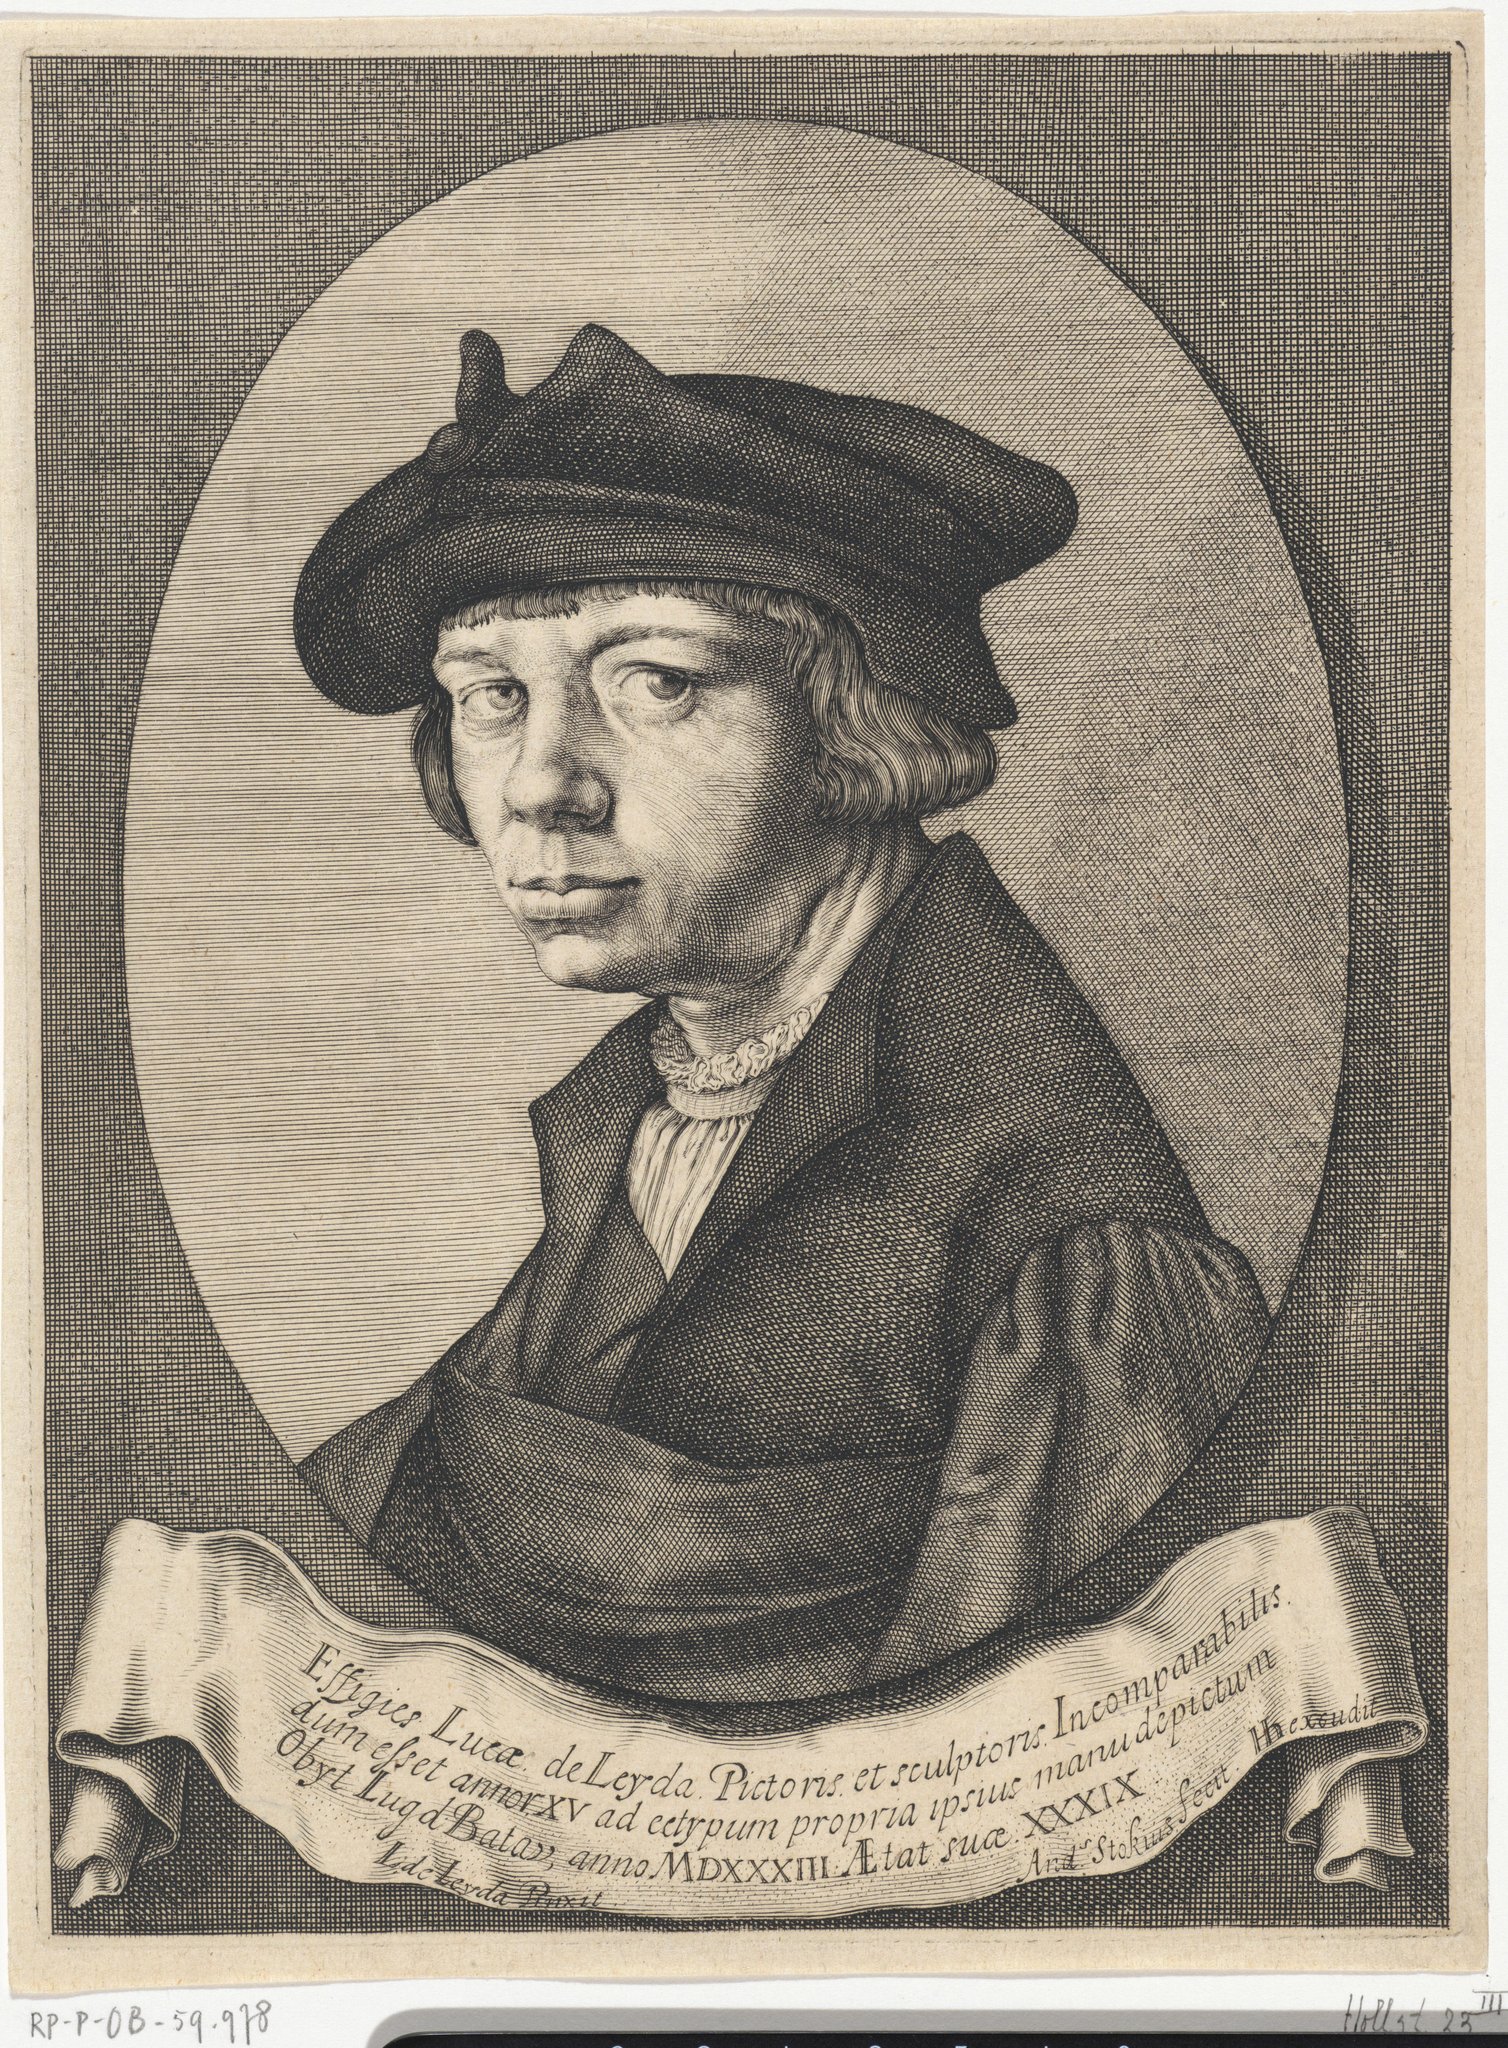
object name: print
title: Portret van Lucas van Leyden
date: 1614-1648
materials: paper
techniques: engraving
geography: the hague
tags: leiden, painter, draughtsman, lucas van leyden, portrait, self-portrait of painter, portrait, self-portrait of graphic artist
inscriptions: collector's mark: Lugt 2228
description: Portret van de schilder en prentmaker Lucas van Leyden met een baret op het hoofd. Onder het portret een banderol een drieregelige tekst in het Latijn met zijn naam, functie en levensdata.